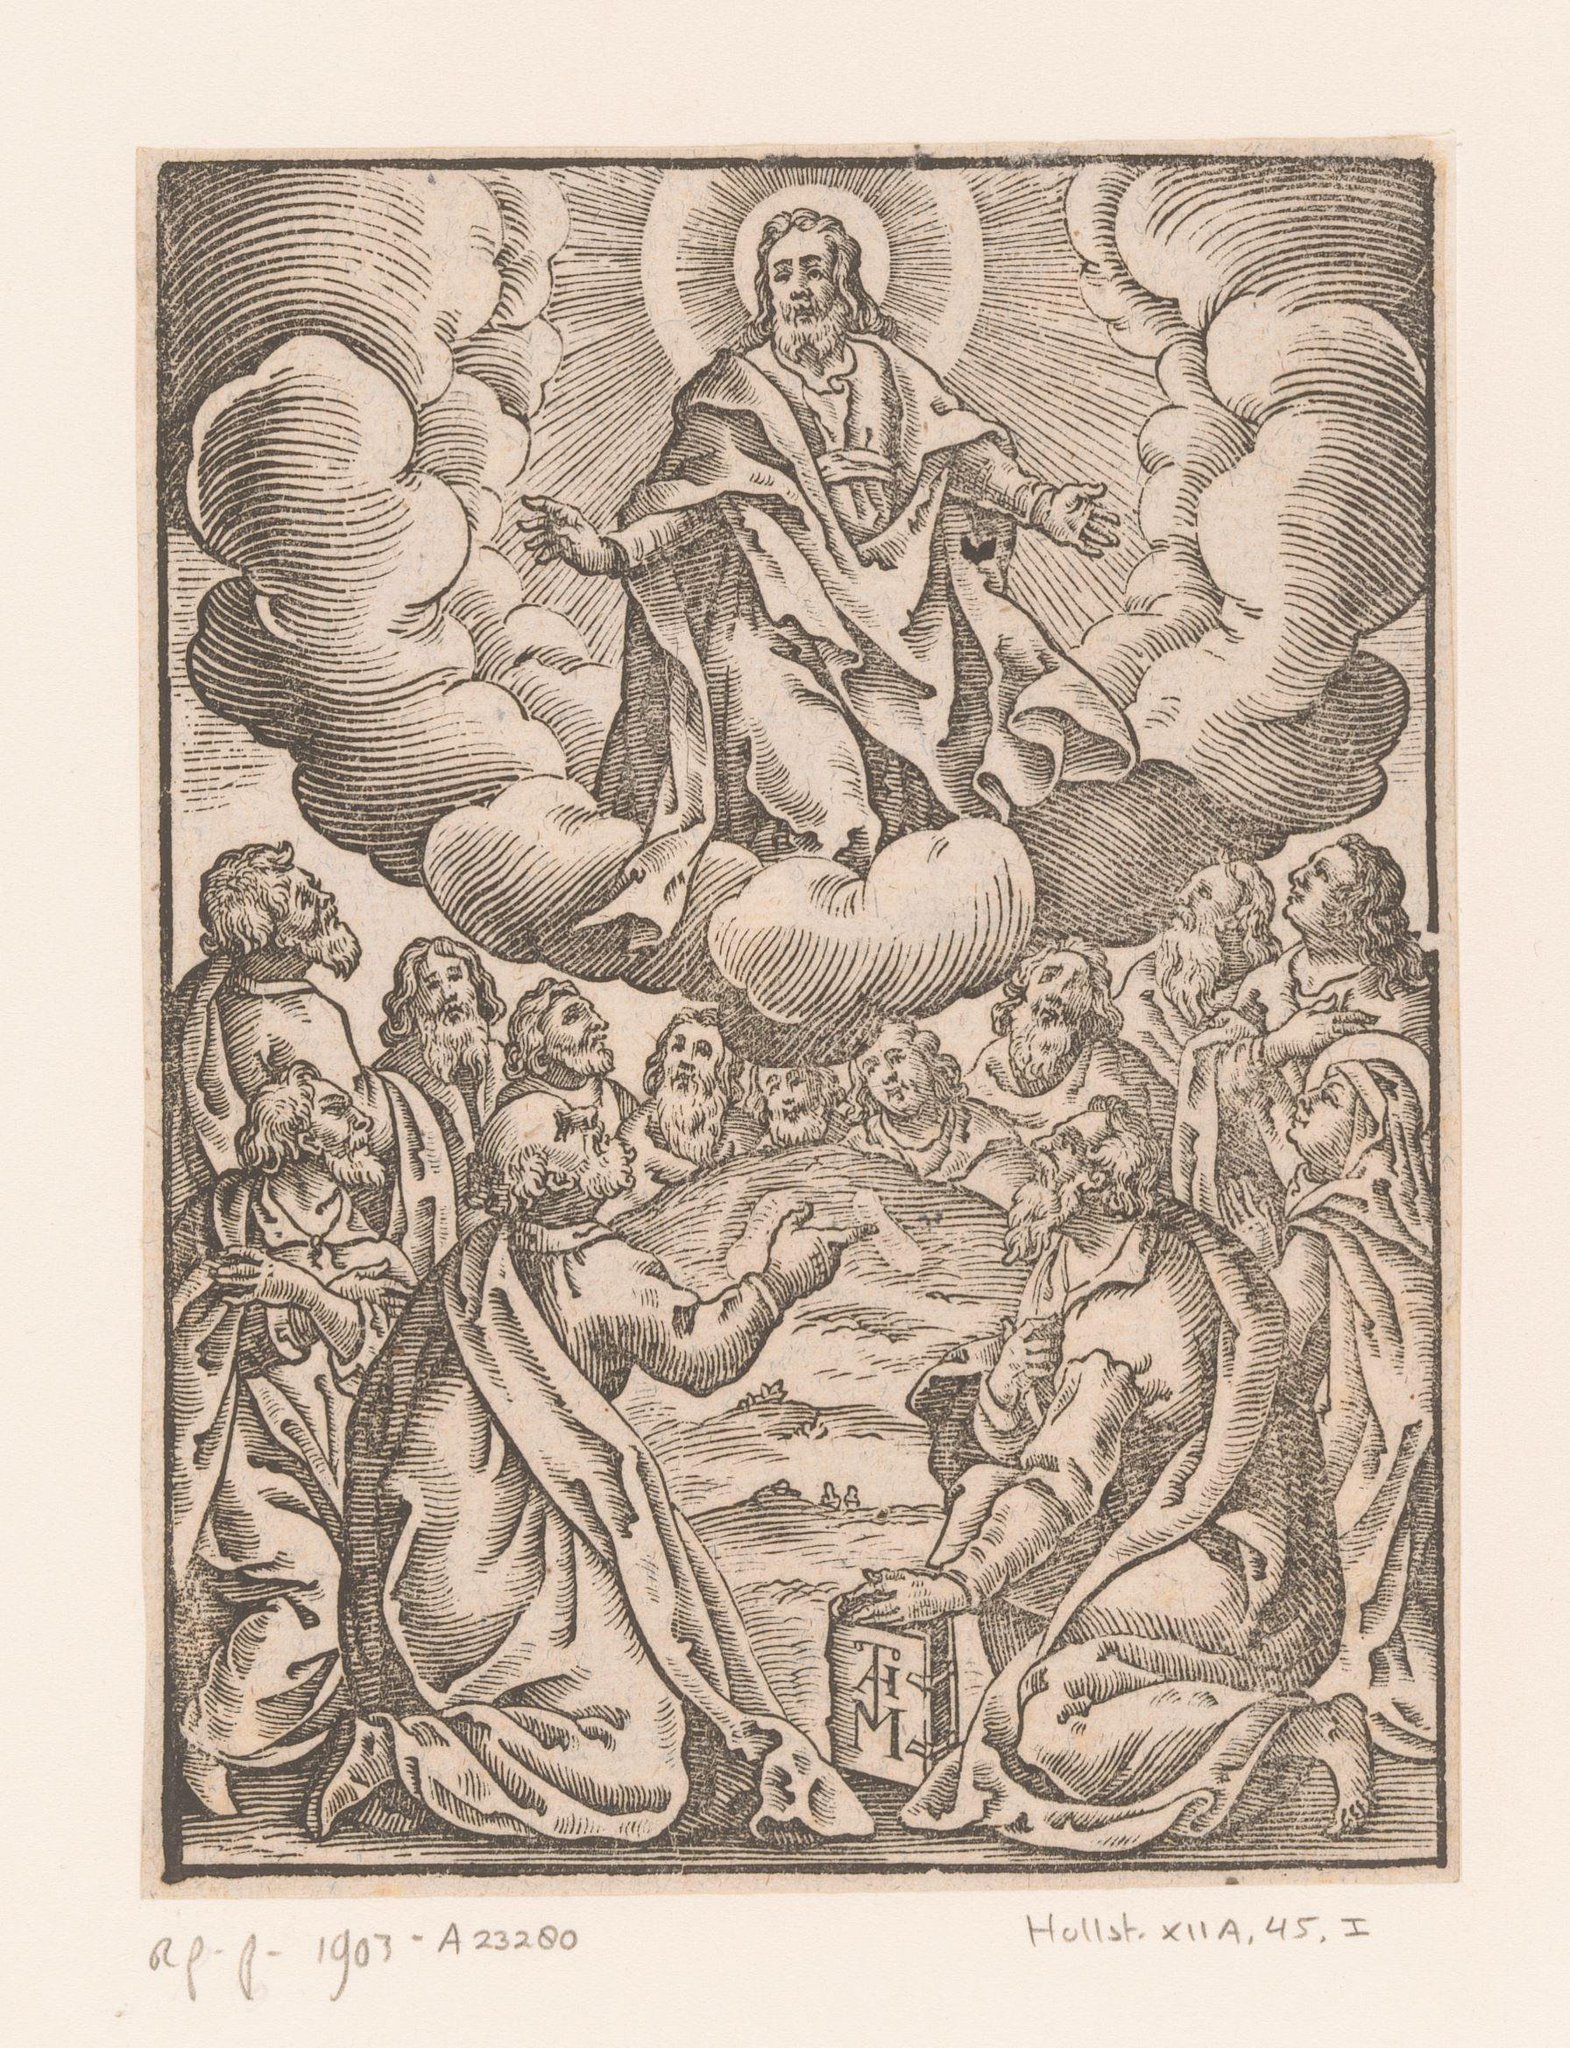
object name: print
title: Hemelvaart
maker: marx anton hannas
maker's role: print maker, publisher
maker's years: 1600-1676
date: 1610-1676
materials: paper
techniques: woodcut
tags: the ascension (christ surrounded by radiant light or in a mandorla)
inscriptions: collector's mark: Lugt 2228